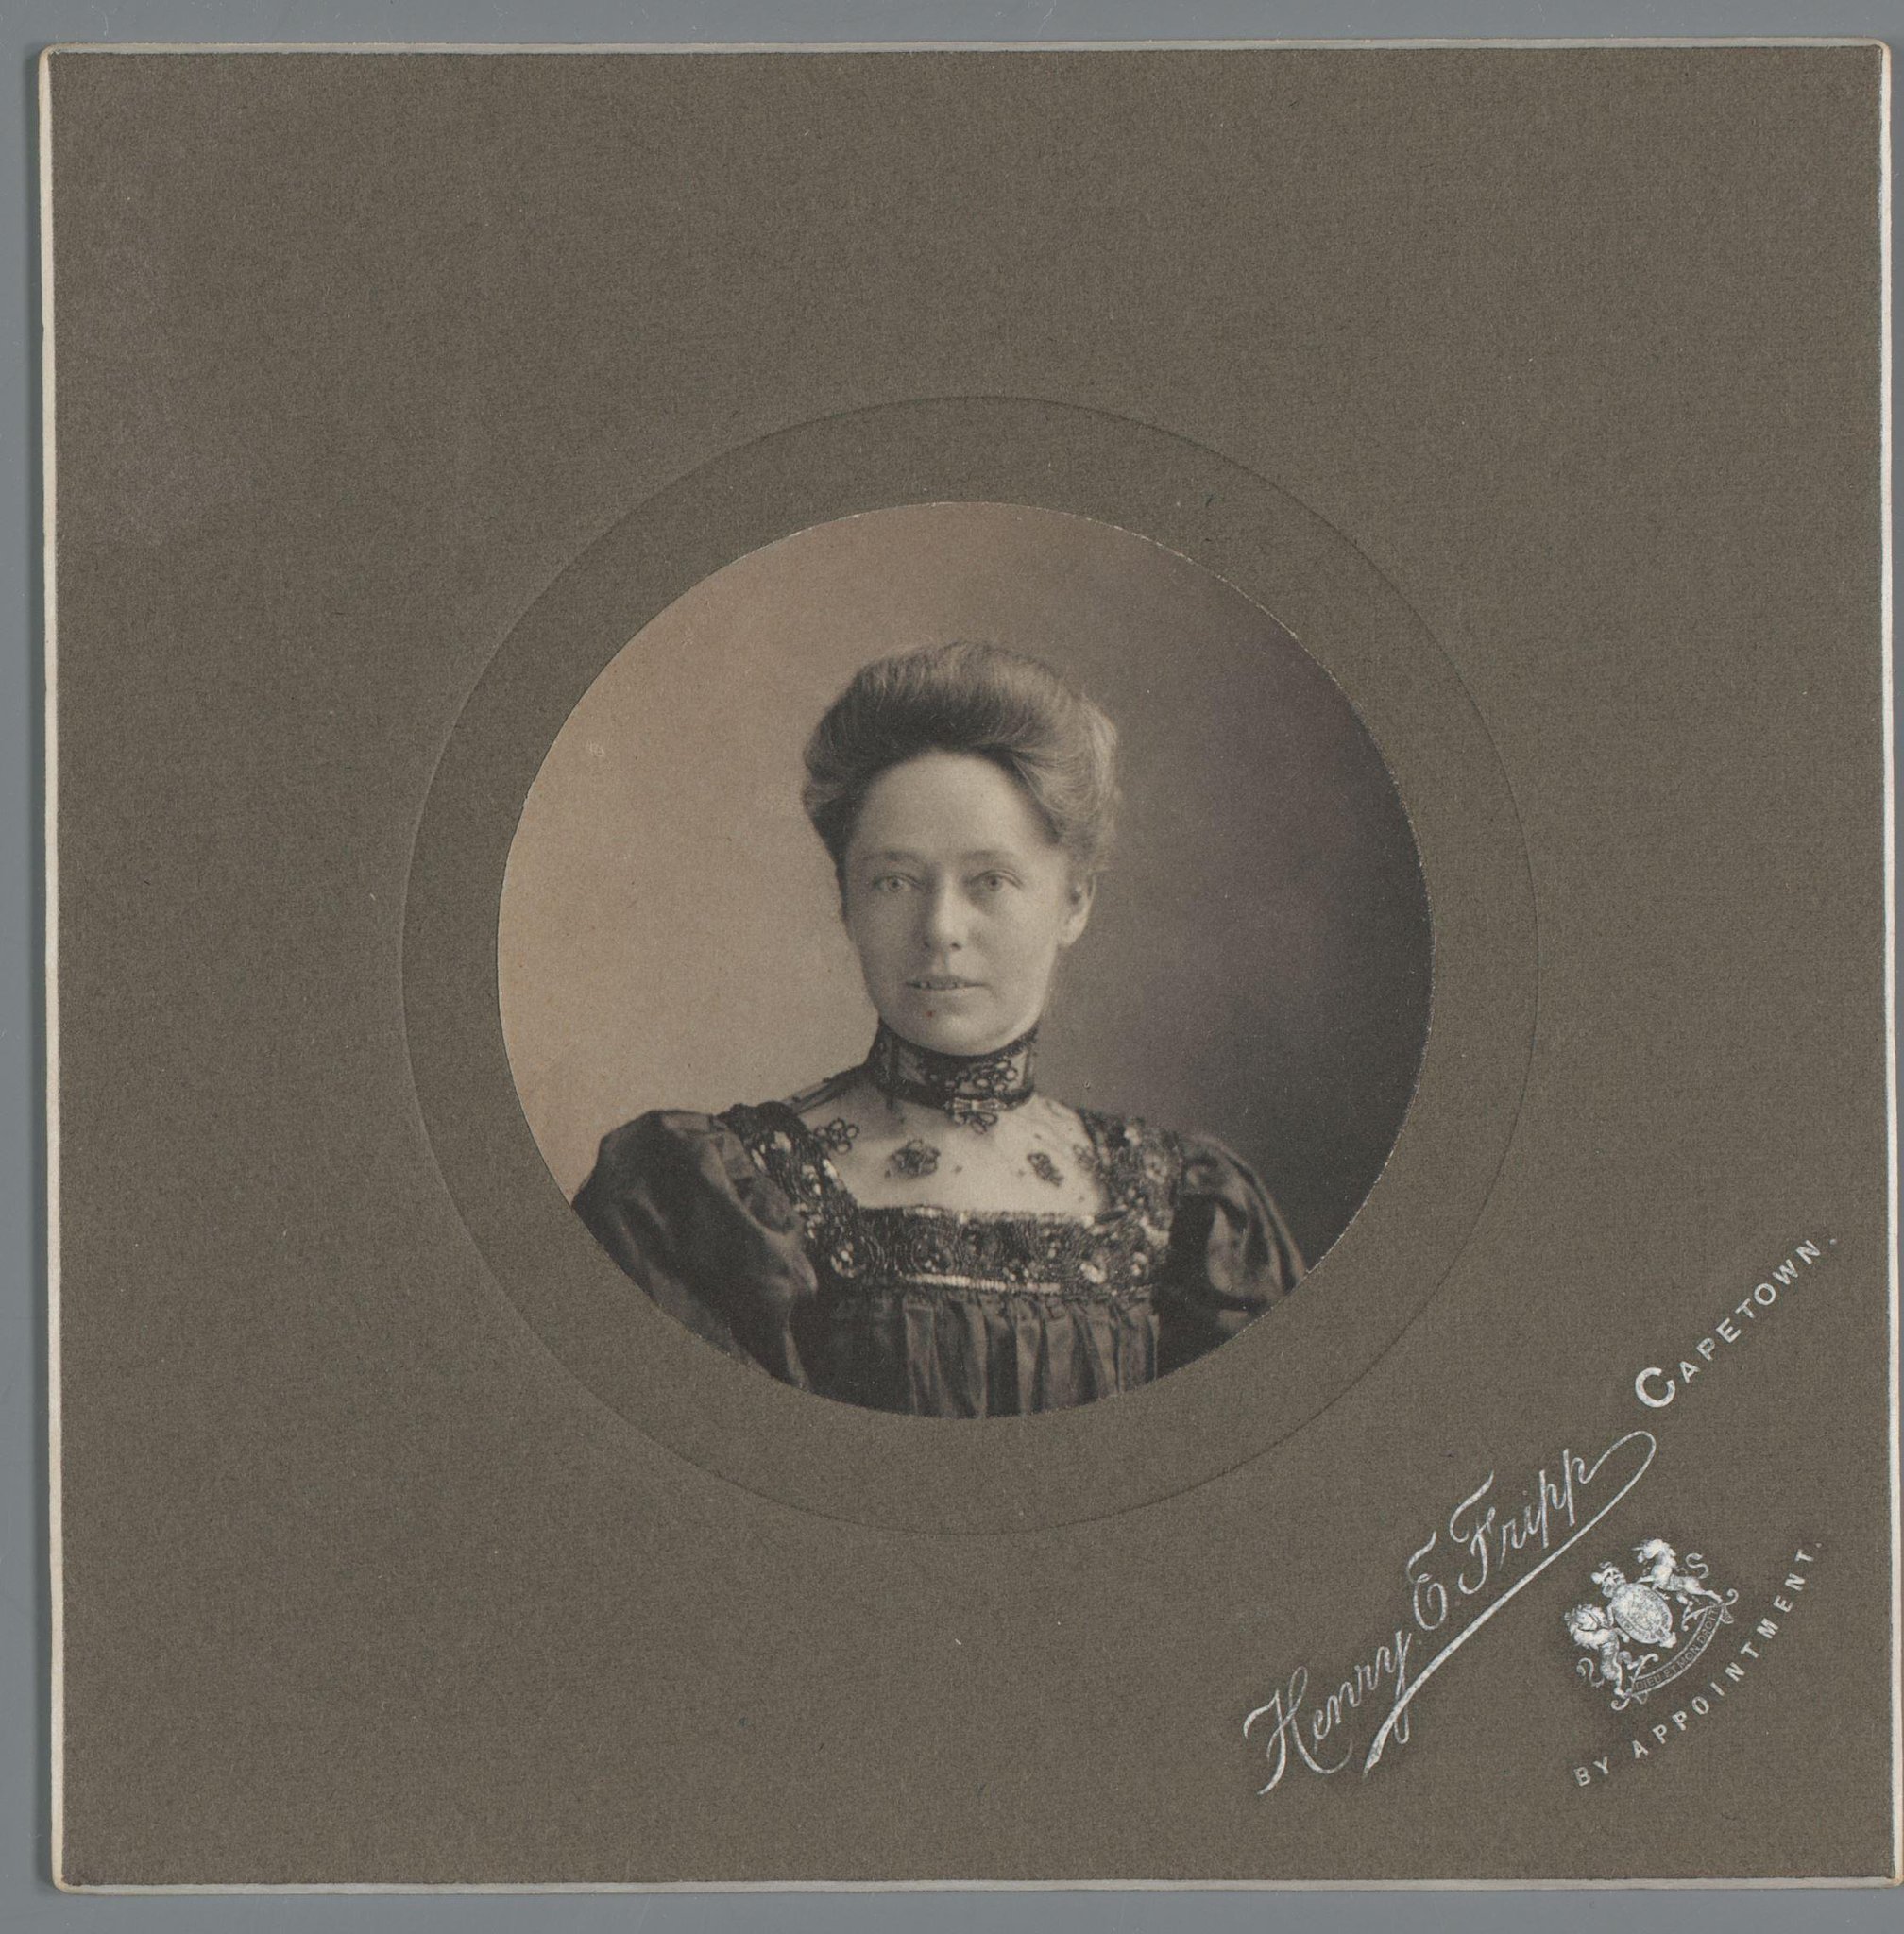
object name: photograph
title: Portret van Anna Gesiena Jonker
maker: henry edward fripp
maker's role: fotograaf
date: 1910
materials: cardboard, photographic support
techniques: platinum process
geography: cape town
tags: historical persons